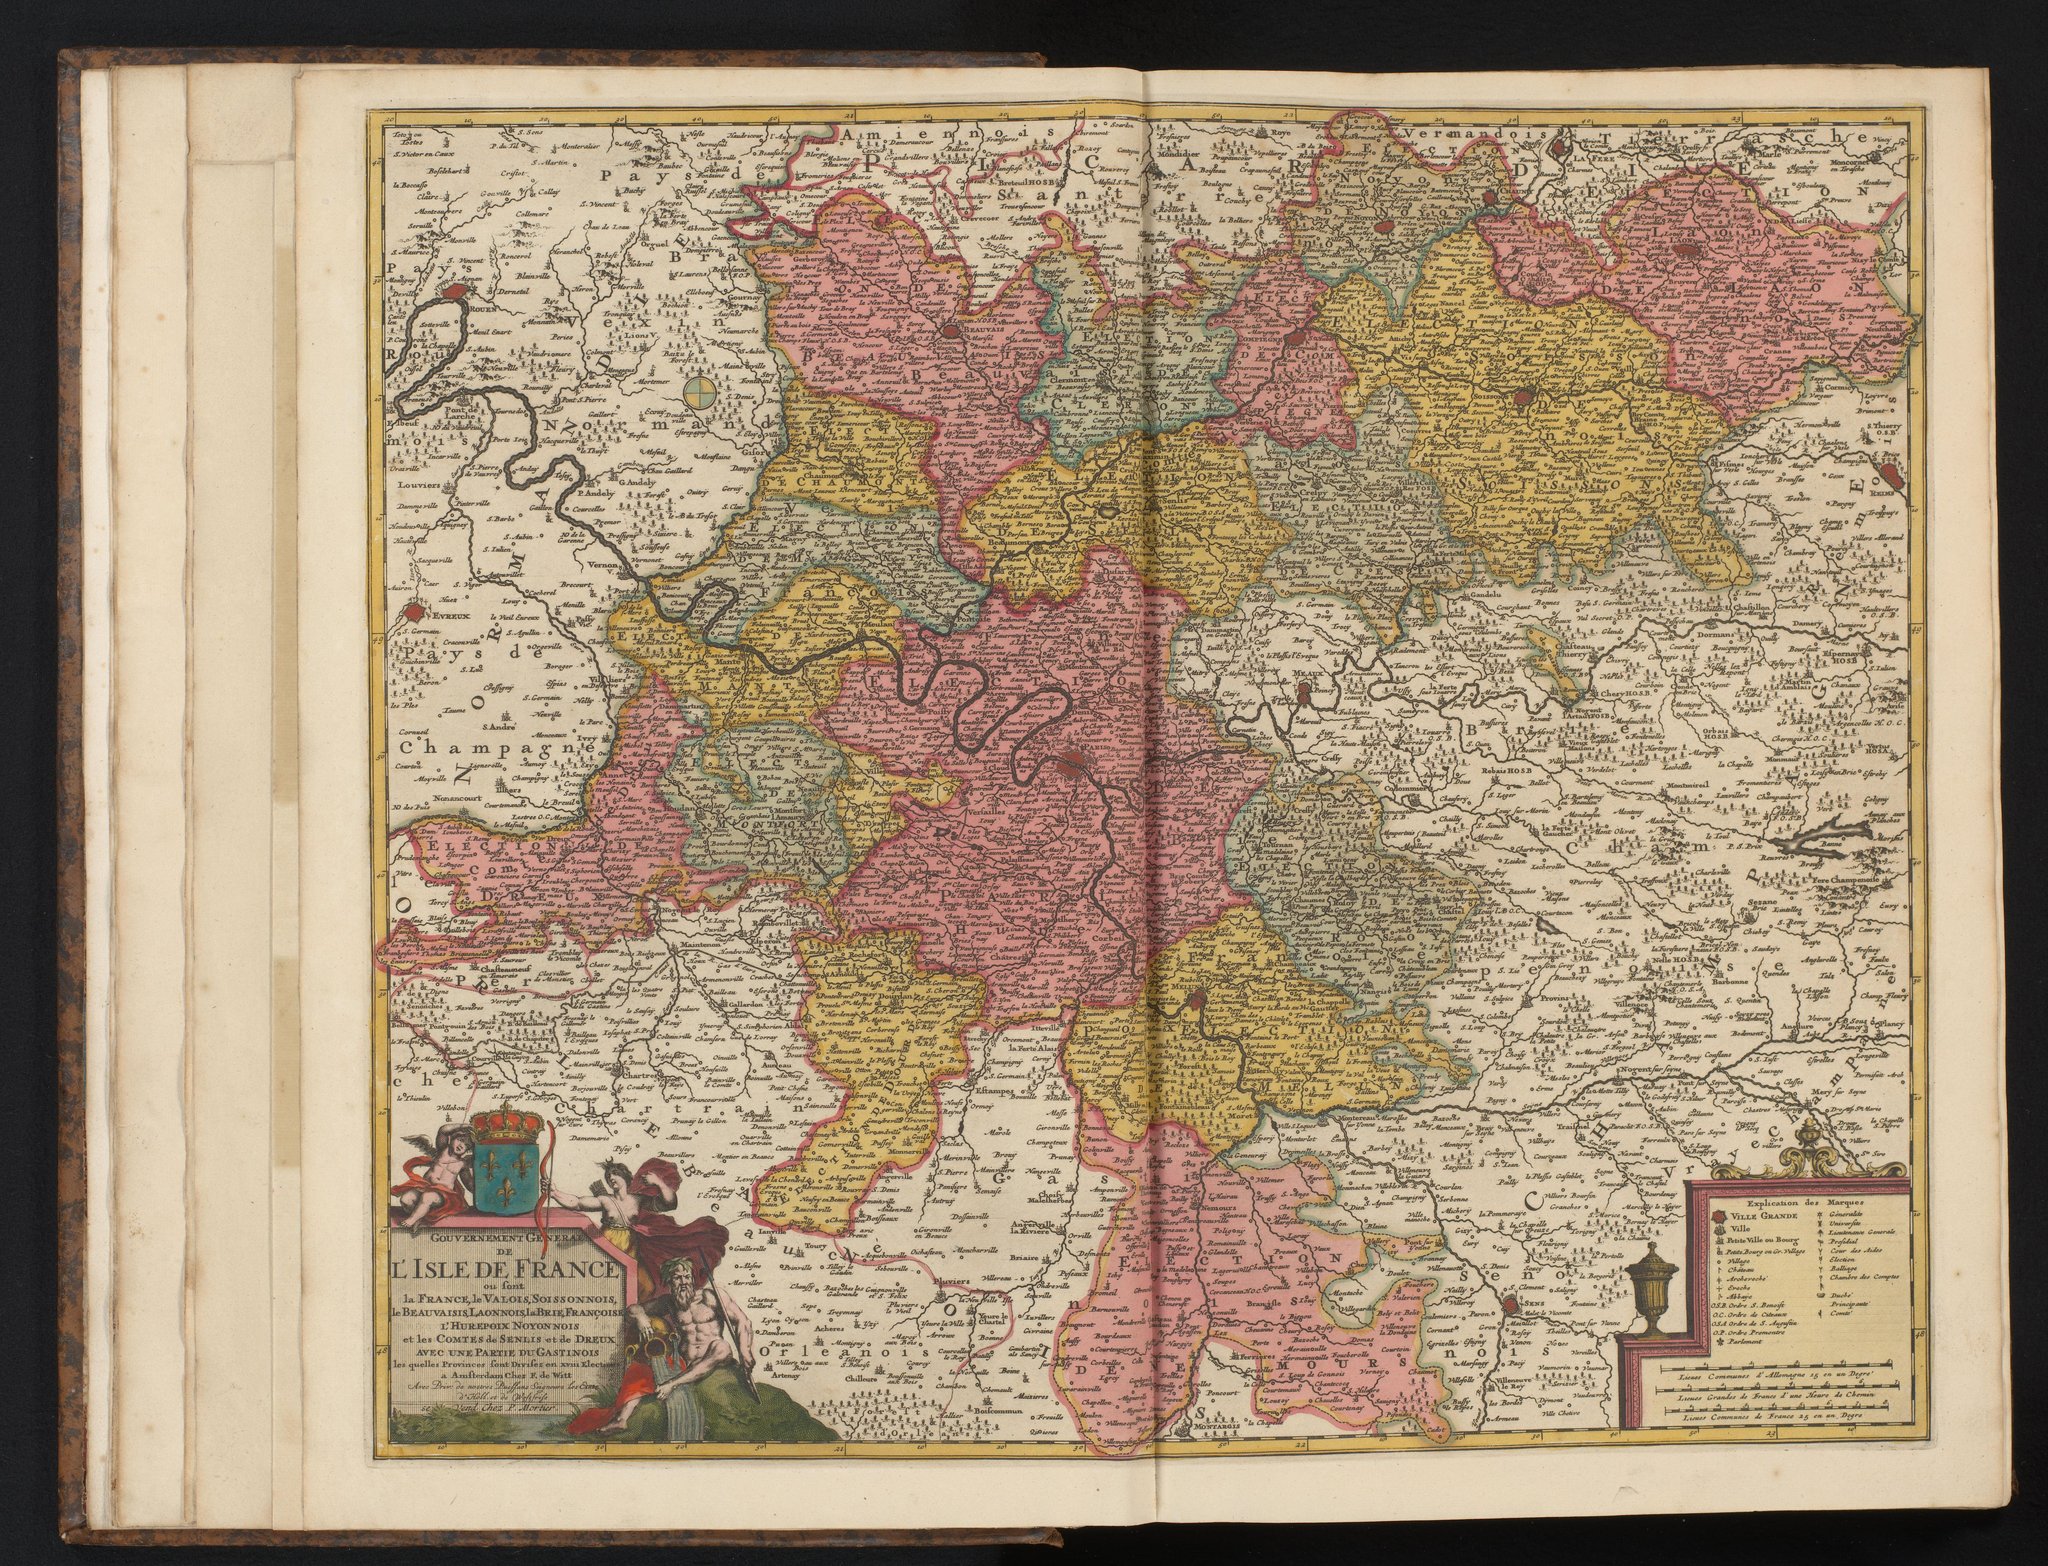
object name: print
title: Kaart van Île-de-France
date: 1685-1706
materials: paper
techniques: engraving, hand coloring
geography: amsterdam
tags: (story of) diana (artemis), maps of separate countries or regions, (story of) cupid, amor (eros)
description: Kaart van de regio Île-de-France. Linksonder Amor met het Franse wapenschild. Daarnaast de godin Diana en een stroomgod. Prent maakt deel uit van een album.